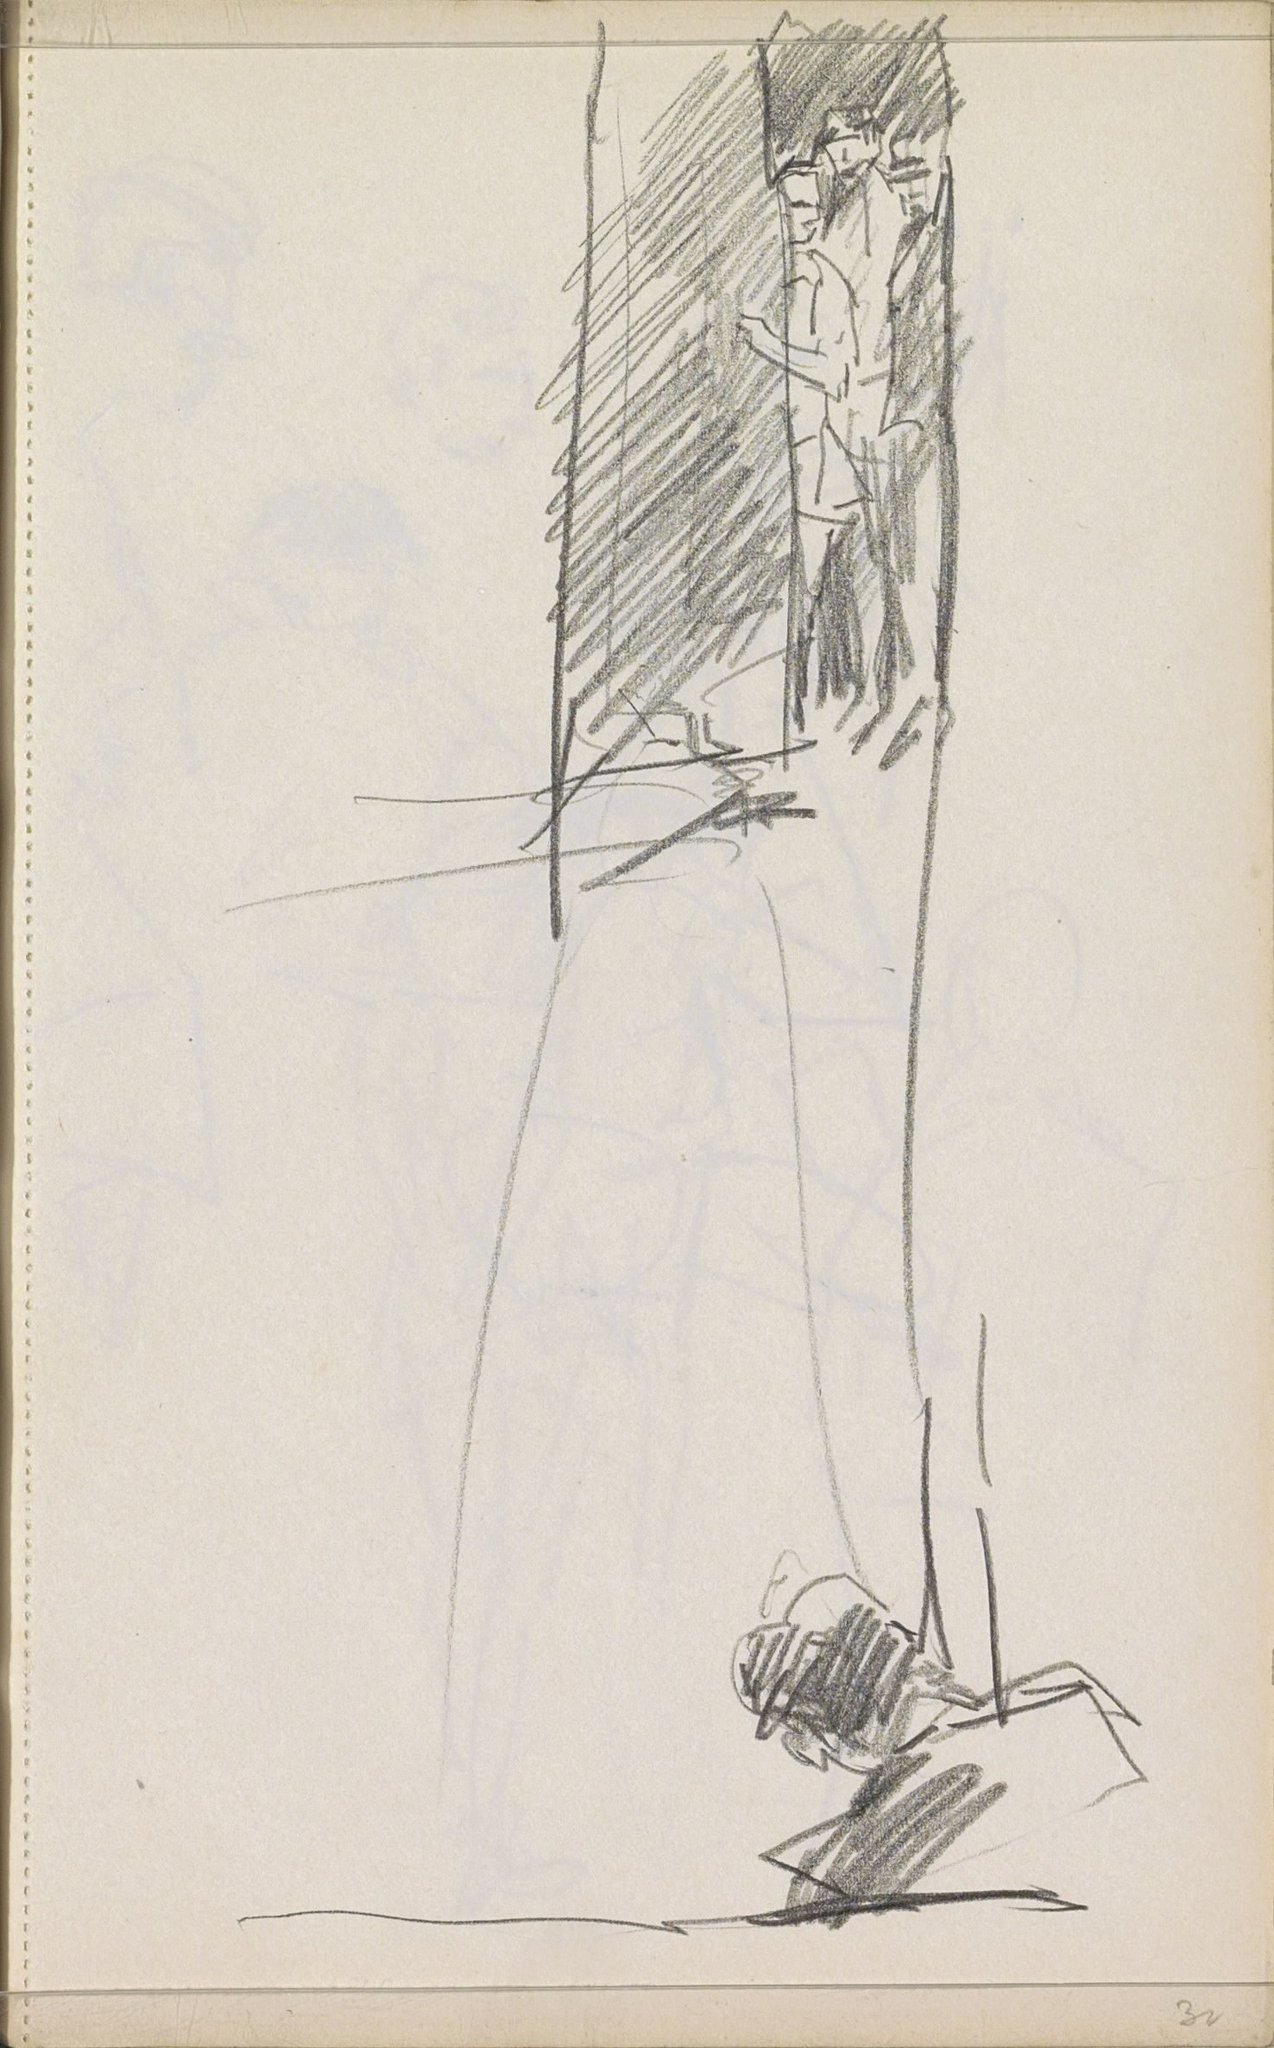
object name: sketchbook leaf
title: Figuren, mogelijk tussen coulissen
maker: isaac israels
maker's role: draughtsman, painter, print maker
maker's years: 1865-1934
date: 1875-1934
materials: paper, pencil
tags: standing figure, behind the stage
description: Blad 30 recto uit schetsboek LII met 43 bladen.